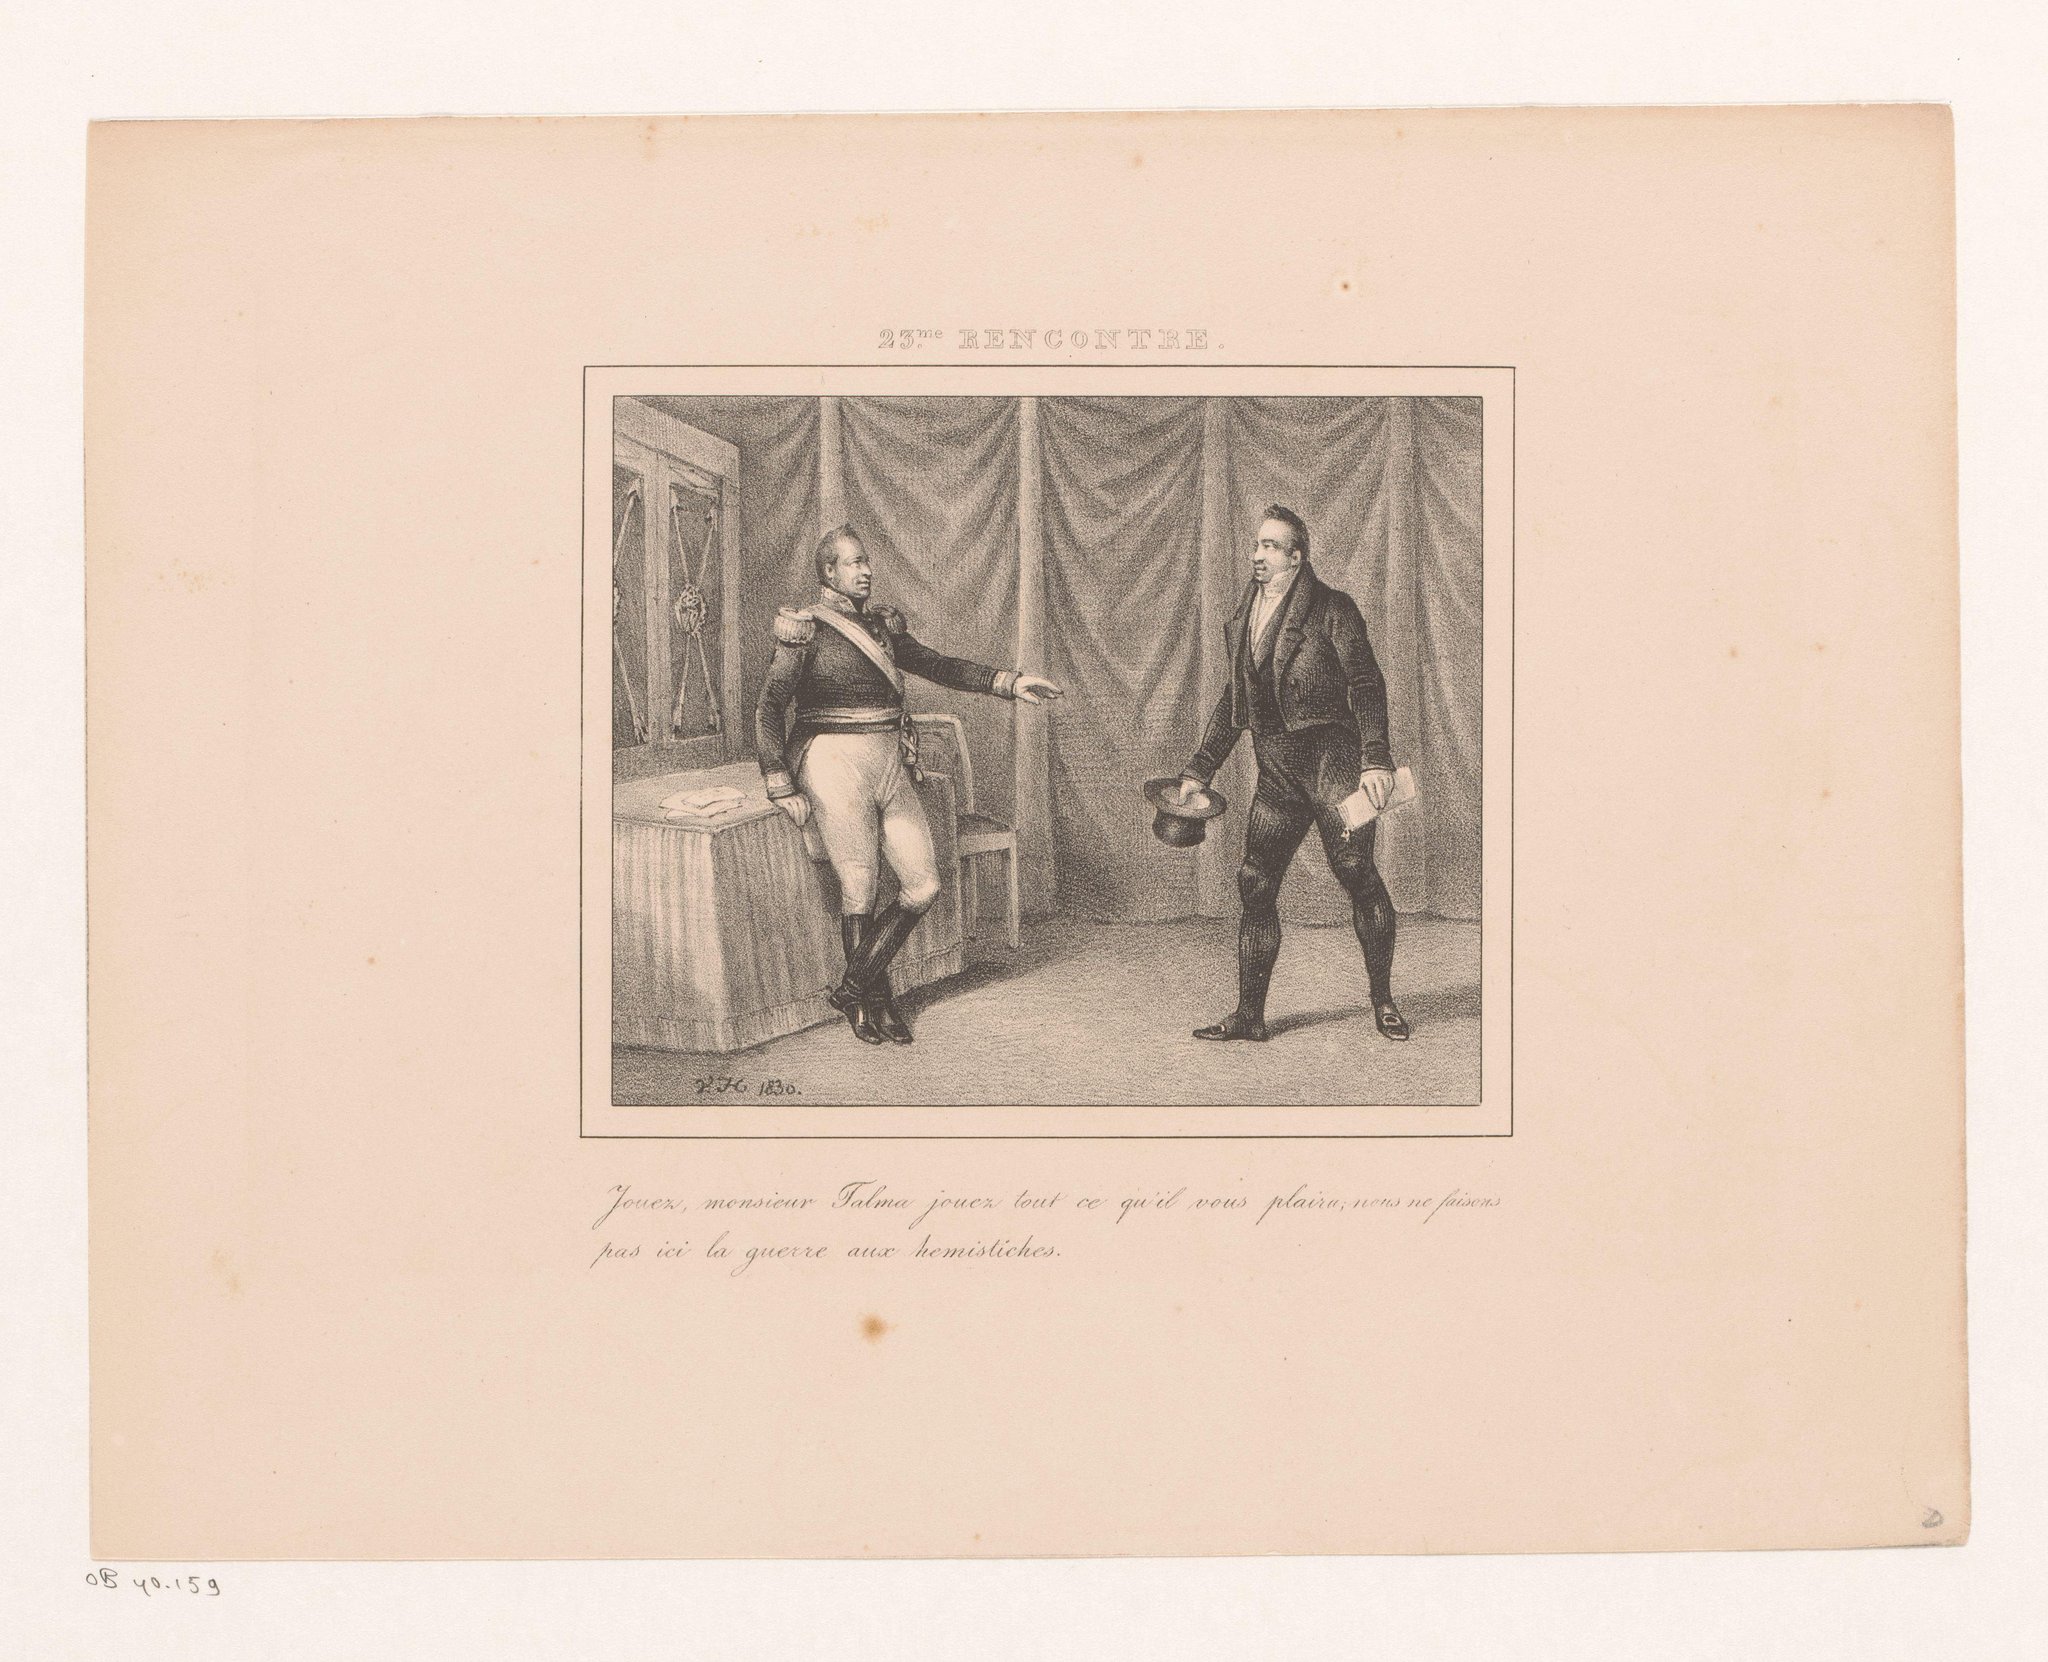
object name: print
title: Ontmoetingen met koning Willem I, 1829-1830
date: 1830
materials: paper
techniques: lithograph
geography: brussels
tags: paris, the hague, berlin, william i of the netherlands, adult man (+ two persons), ruler in informal contact with his subjects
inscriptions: collector's mark: Lugt 2228